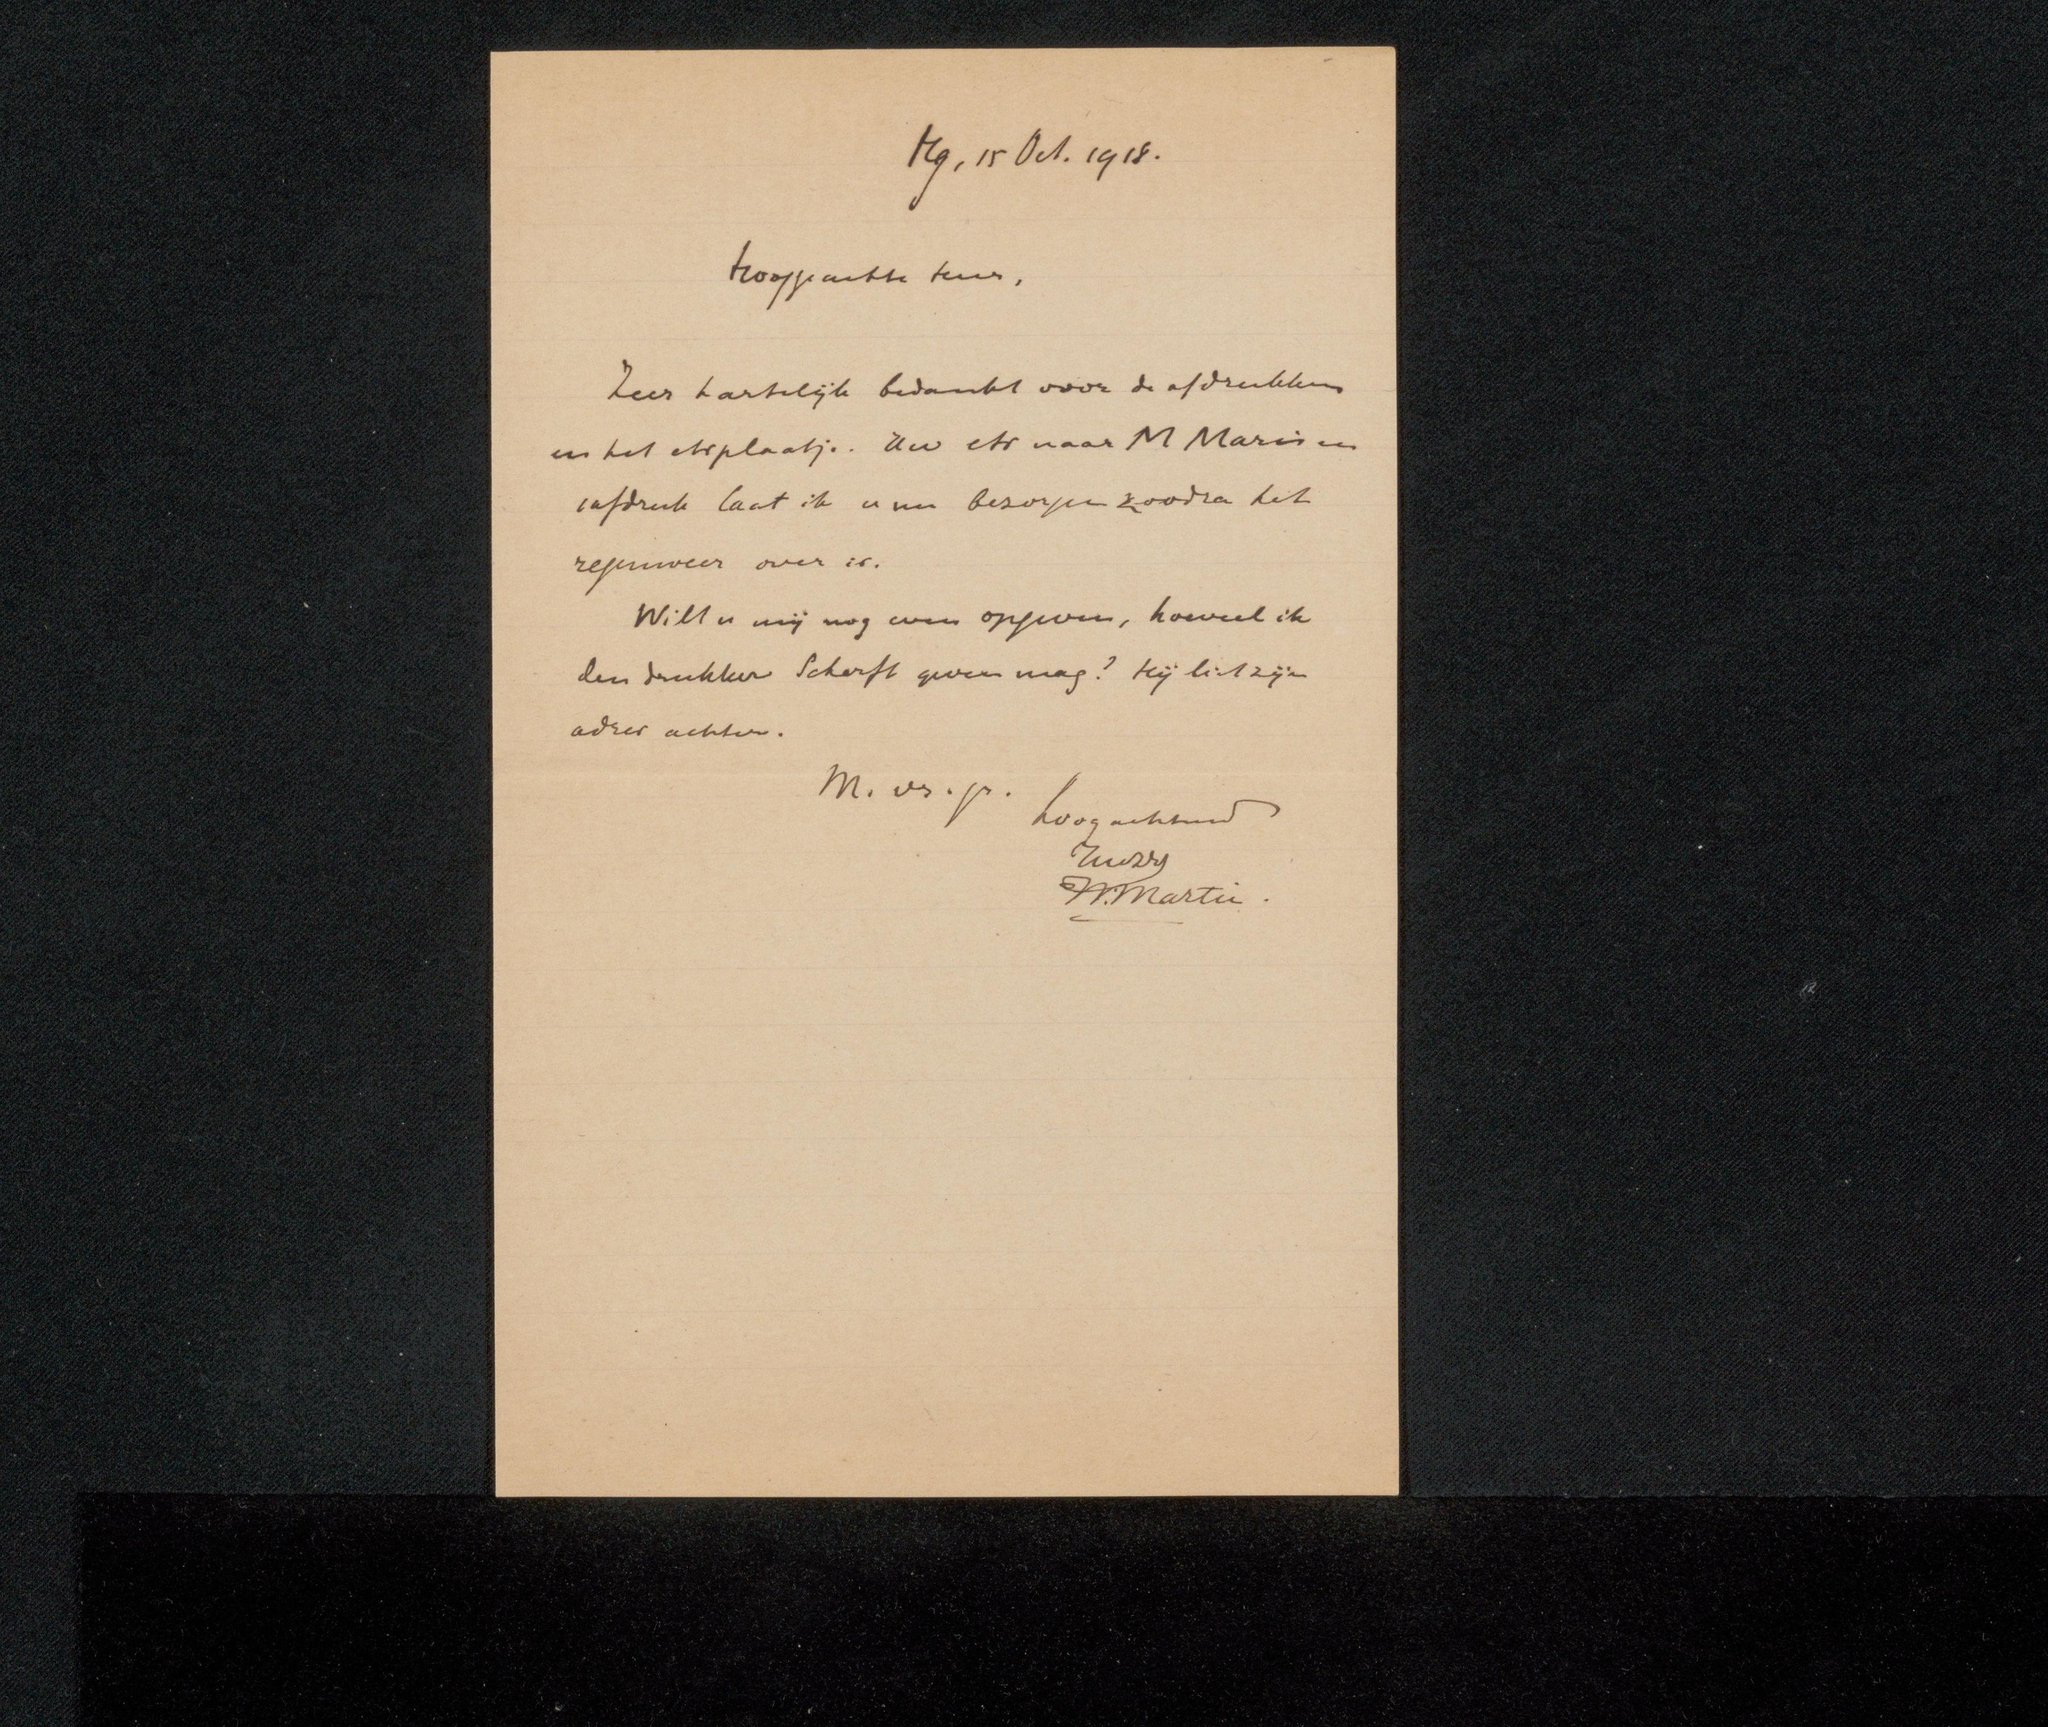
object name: letter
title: Brief aan Philip Zilcken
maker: wilhelm martin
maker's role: draughtsman, painter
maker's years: 1876-1954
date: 1918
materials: ink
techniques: pen, writing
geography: the hague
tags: london, print maker, matthijs maris, johannes d. scherft, painter, draughtsman, philip zilcken, the graphic arts, money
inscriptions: collector's mark: ‘RPK’